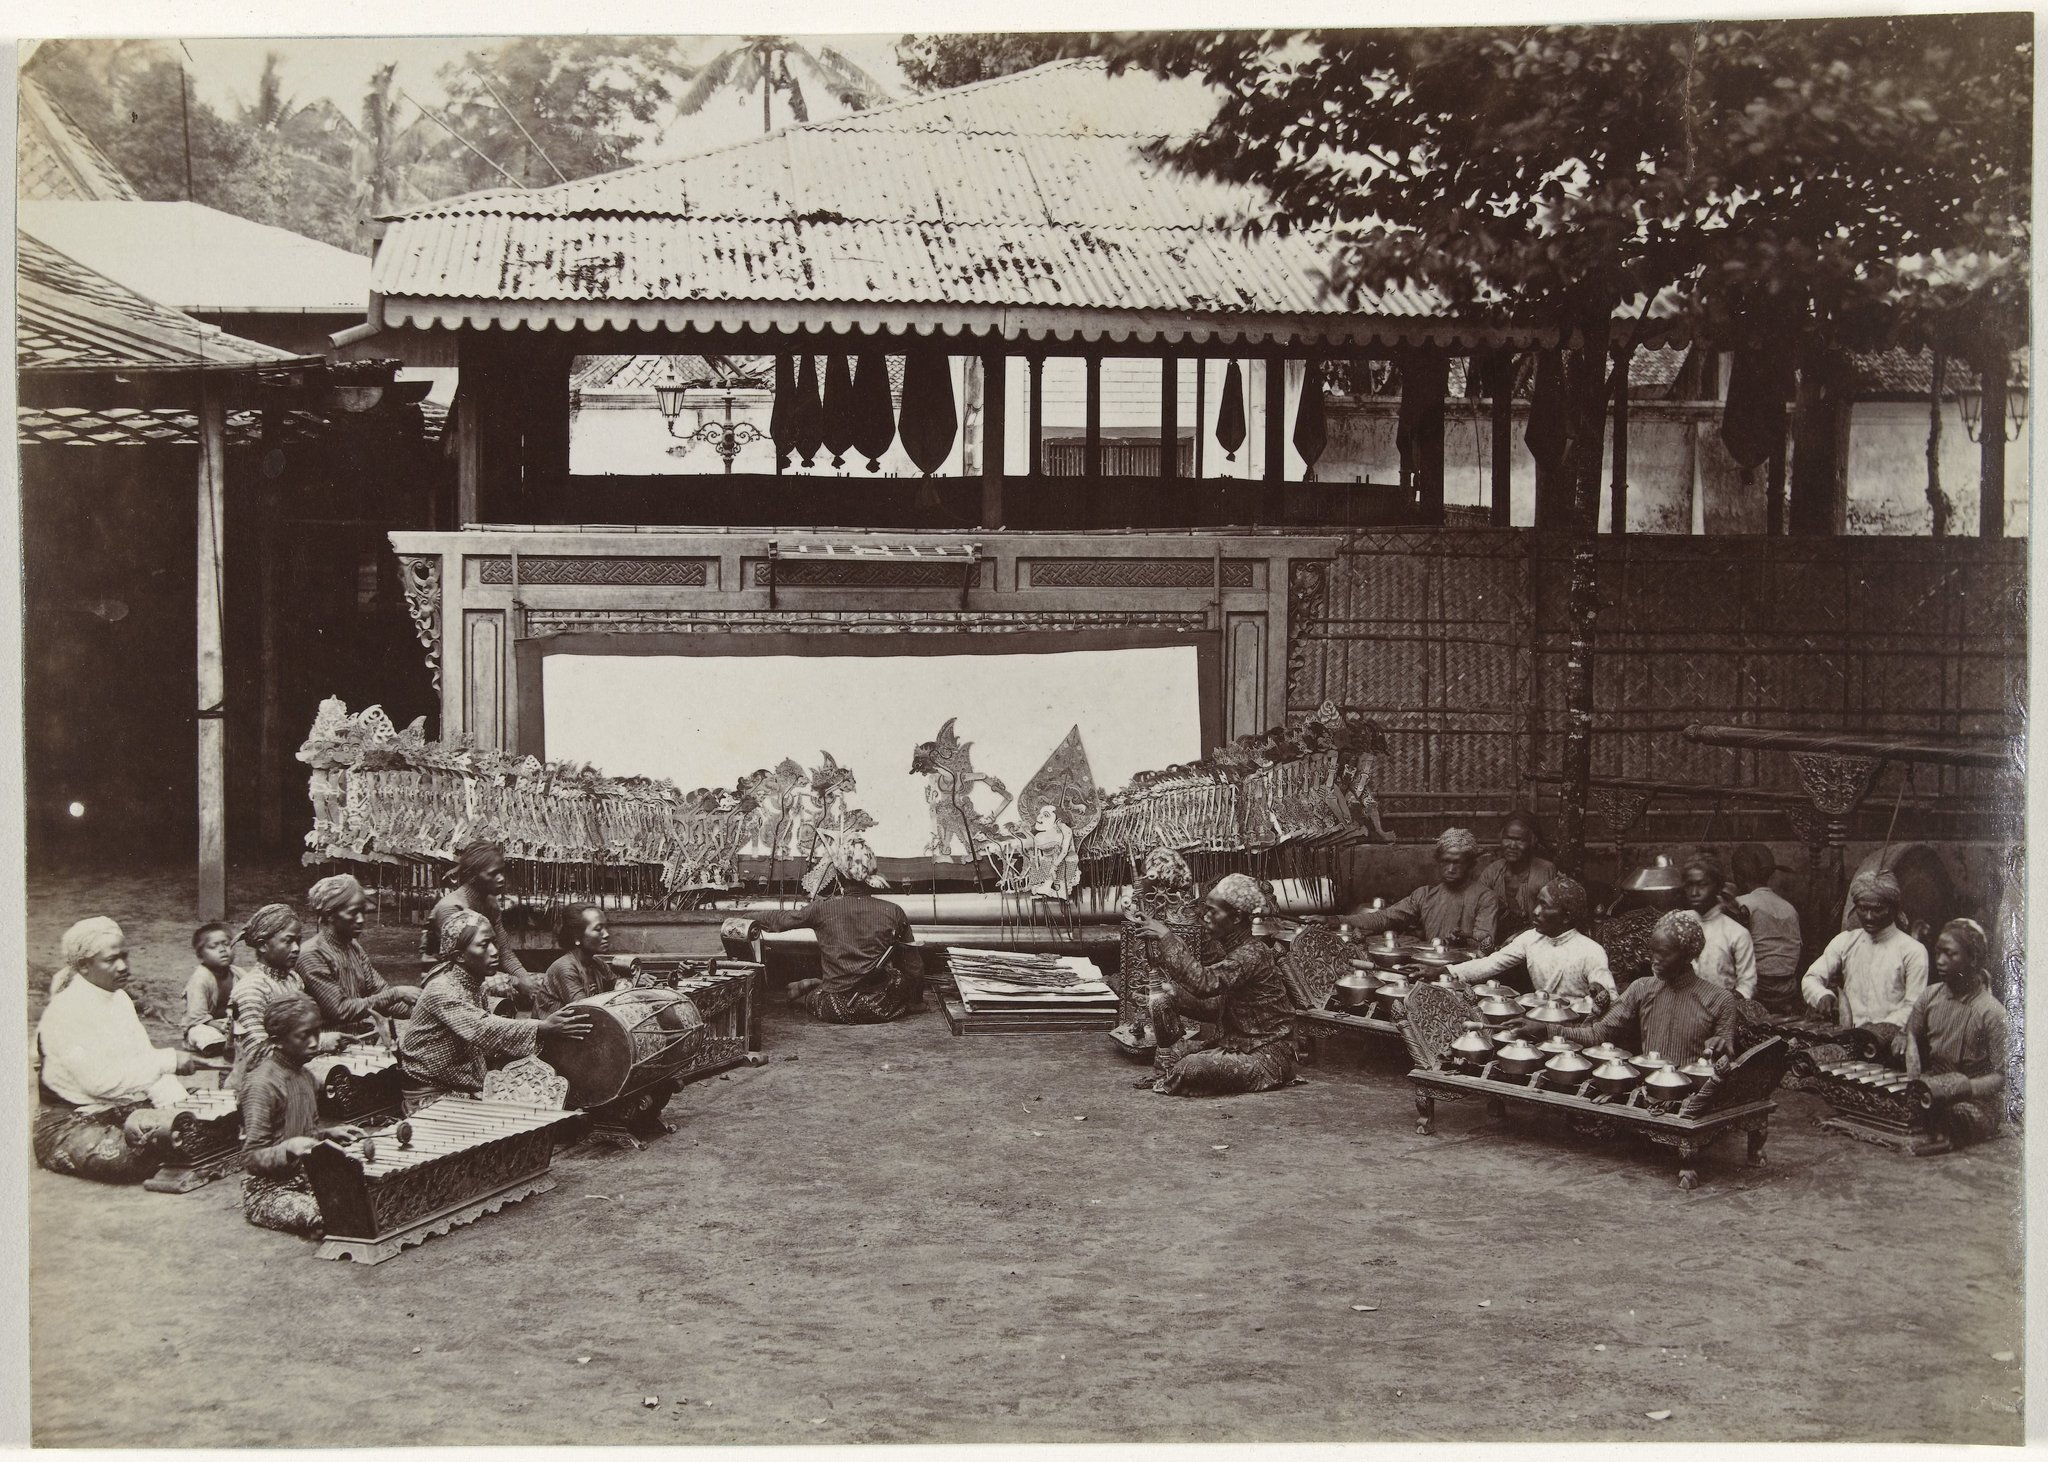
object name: photograph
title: Wayang Kulit onder begeleiding van een gamelanorkest, Nederlands-Indië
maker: kassian céphas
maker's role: fotograaf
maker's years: 1845-1912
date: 1890-1900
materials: paper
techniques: albumen print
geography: jogjakarta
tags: large group of musicians, orchestra, puppet and marionette show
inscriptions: inscription: ‘Wajang (Djokja)’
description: De voorstelling vond plaats tijdens de Sekaten (volksfeest op de geboortedag van de profeet).